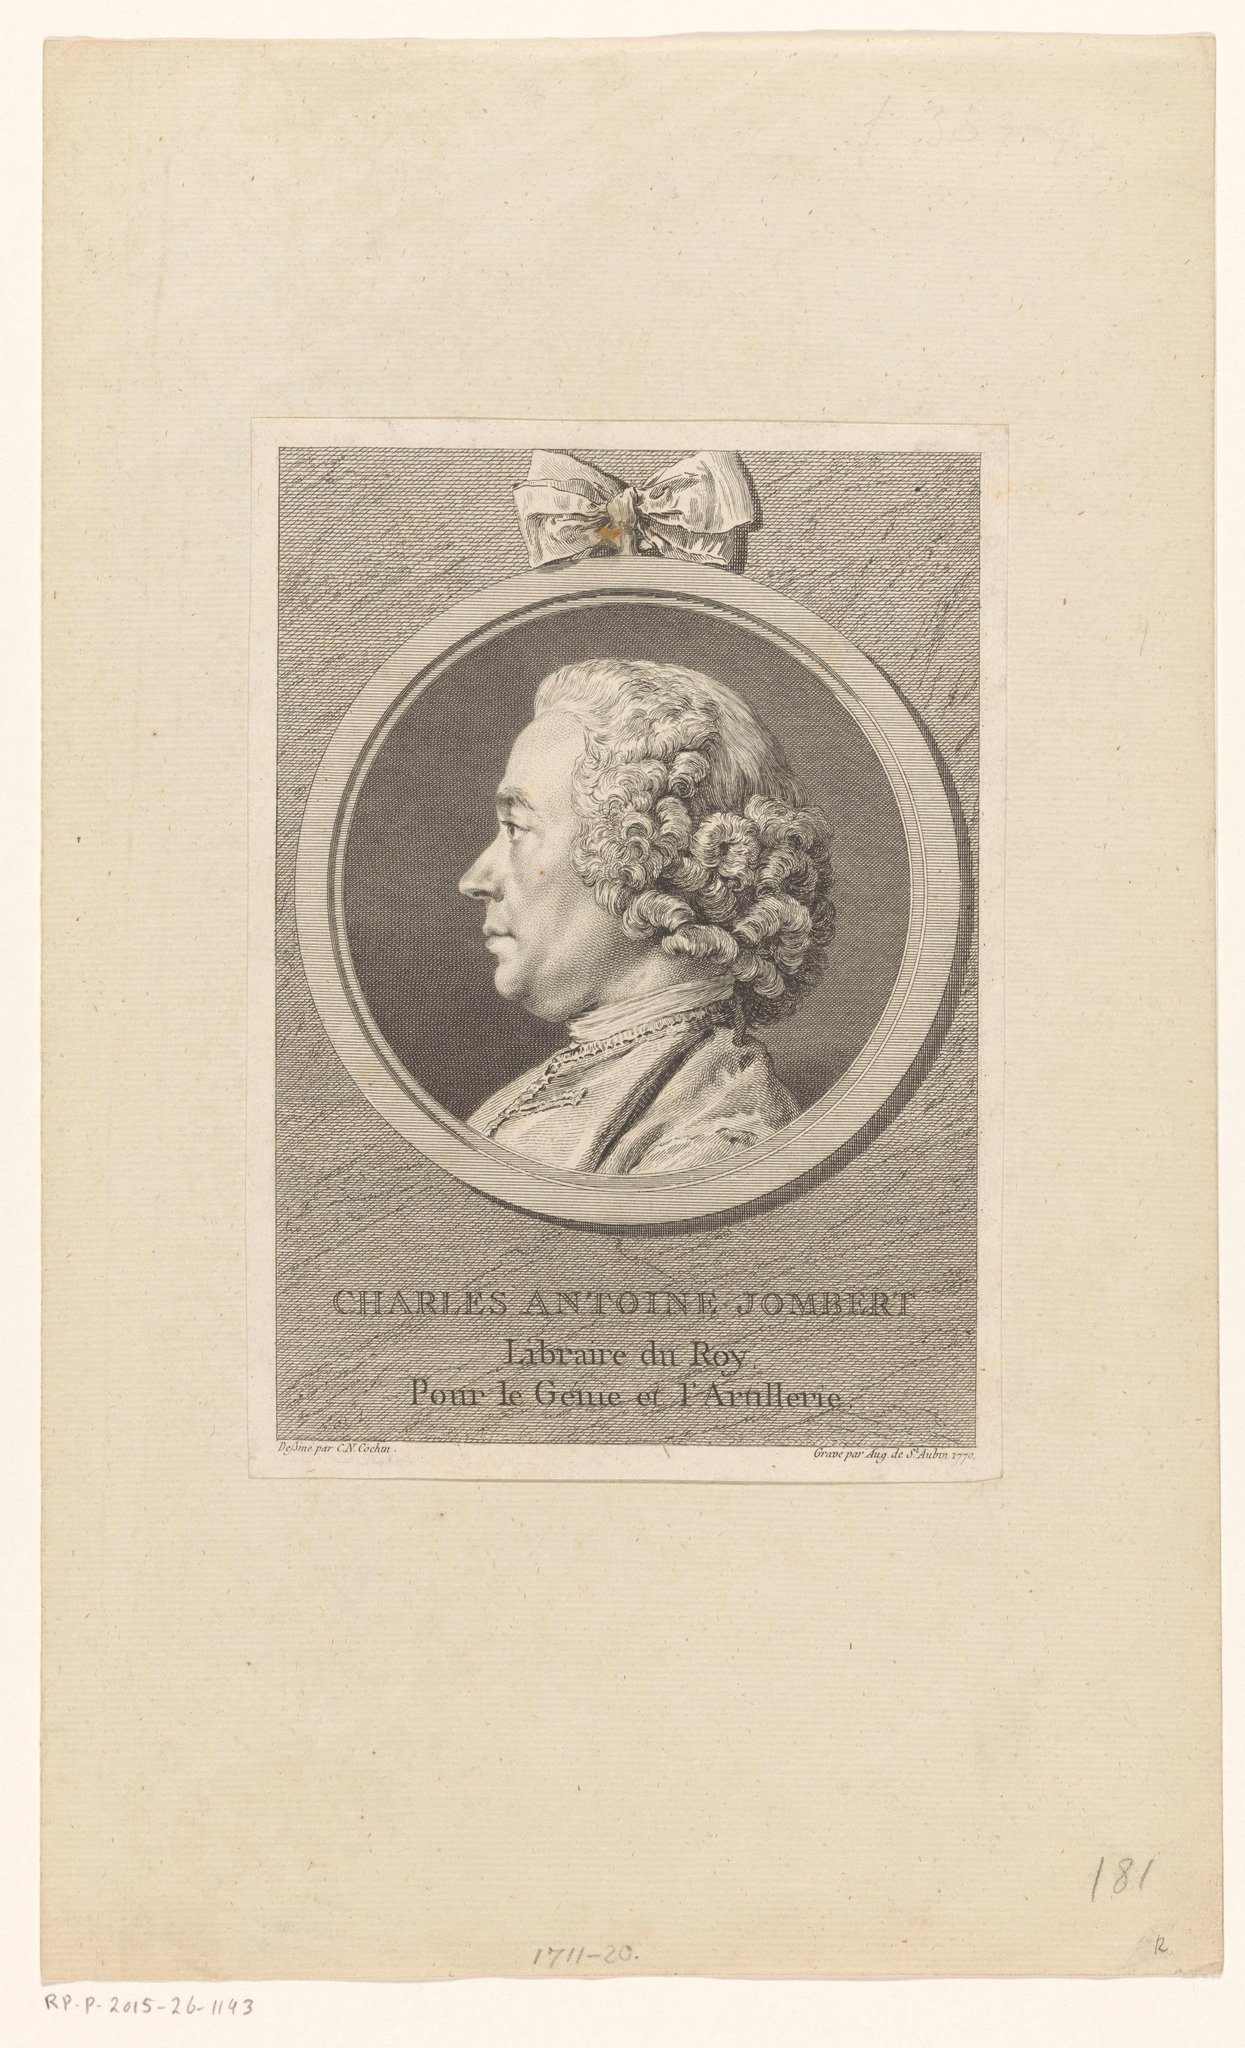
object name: print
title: Portret van Charles Antoine Jombert, boekverkoper en uitgever te Parijs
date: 1770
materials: paper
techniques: etching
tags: paris, publisher, charles-antoine jombert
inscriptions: collector's mark: Lugt 4779, collector's mark: Lugt 2228